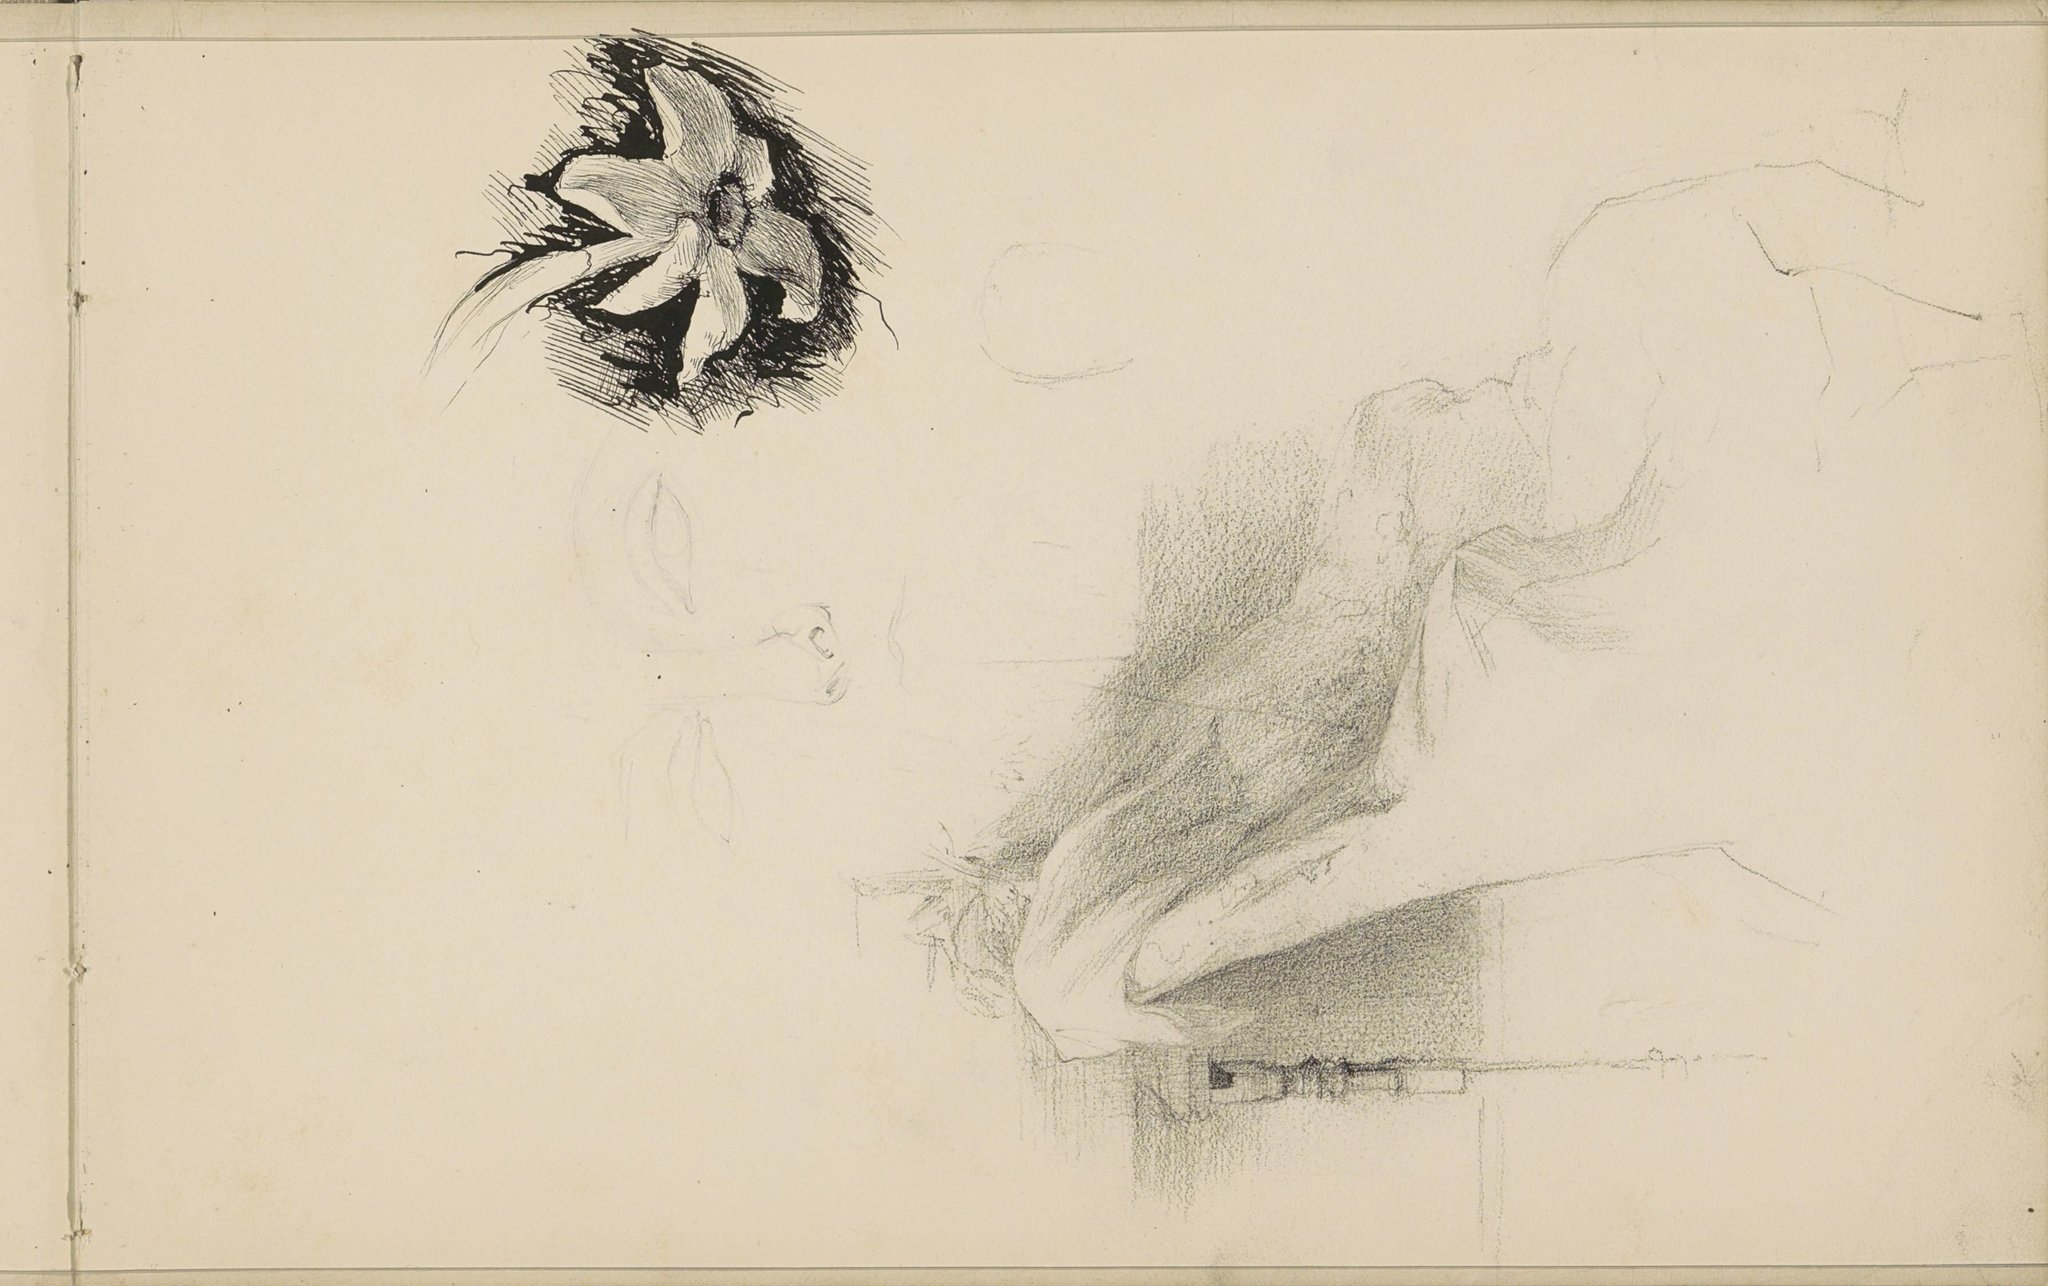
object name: sketchbook leaf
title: Bloem, gezicht van een vrouw en een interieur met een leunstoel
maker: a.a.l. de grammont-hubrecht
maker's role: draughtsman, painter, print maker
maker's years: 1855-1913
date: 1865-1913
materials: chalk, ink, paper, pencil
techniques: pen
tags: flowers, armchair, seat, parts of the face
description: Blad 3 recto uit een schetsboek met 65 bladen.